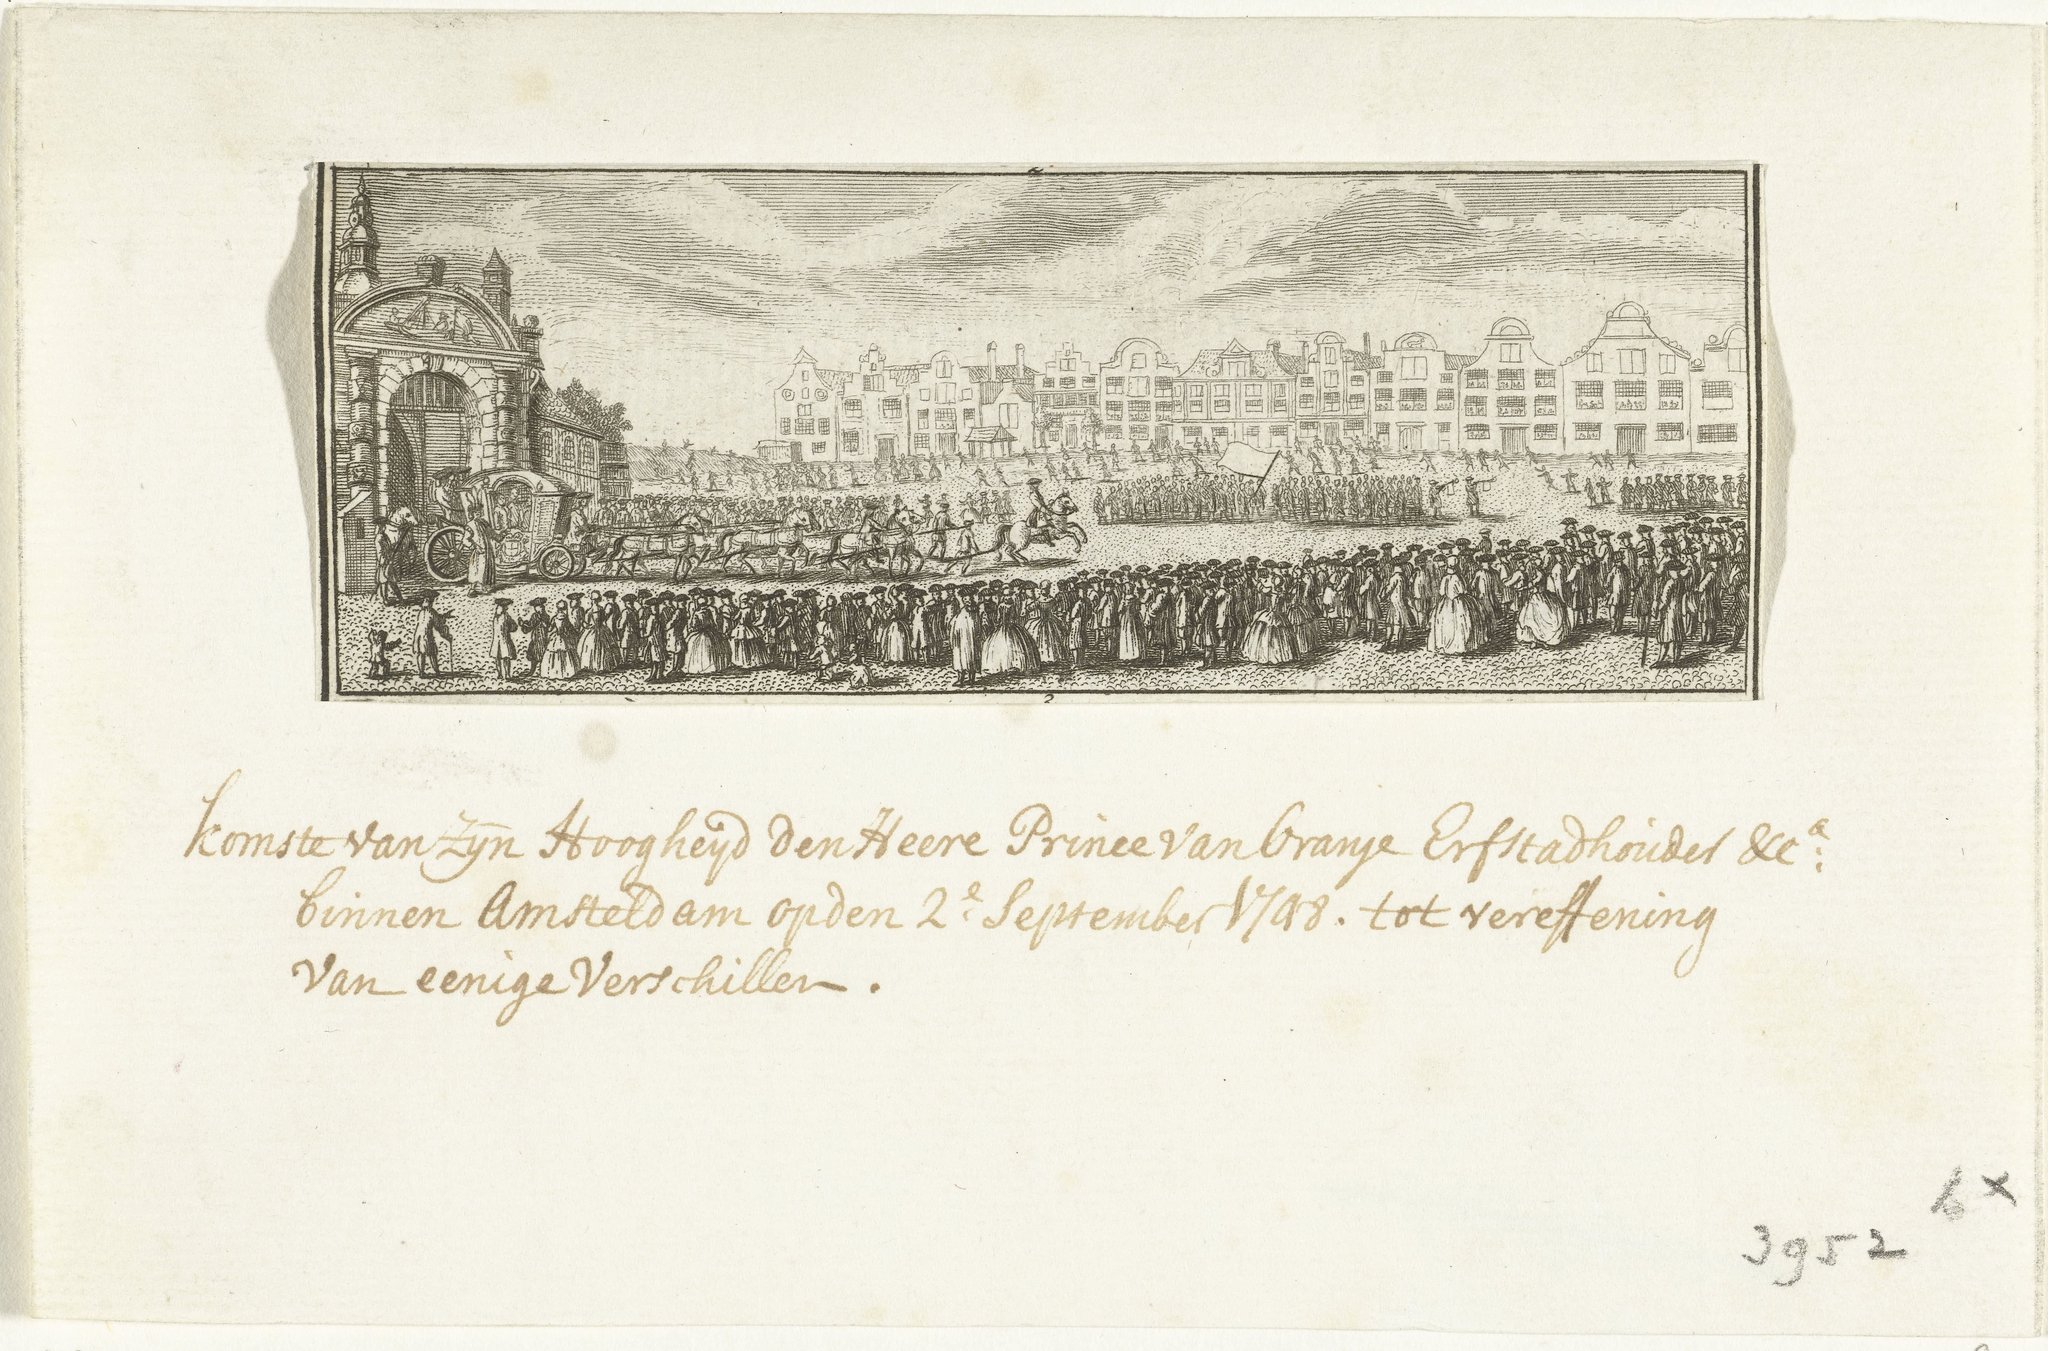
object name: print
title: komste van zyn Hoogheyd den Heere Prince van Oranje Erfstadhouder &ca: binnen Amsteldam op den 2e. September 1748. tot vereffening van eenige verschillen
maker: Anonymous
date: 1748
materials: paper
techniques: etching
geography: northern netherlands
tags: the hague, willem iv (prins van oranje-nassau), triumphal entry and public reception, pageant, 'entrée solennelle', 'joyeuse entrée', amsterdam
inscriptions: collector's mark: Lugt 2228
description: Aankomst van prins Willem IV te Amsterdam op 2 september 1748. De koets met de stadhouder rijdt door de Haarlemmerpoort de stad binnen en wordt feestelijk toegejuicht door publiek langs de weg en begeleid door een korps met een vaandel. Kleine prent uitgeknipt en op een blad geplakt waarop de handgeschreven opschrift.